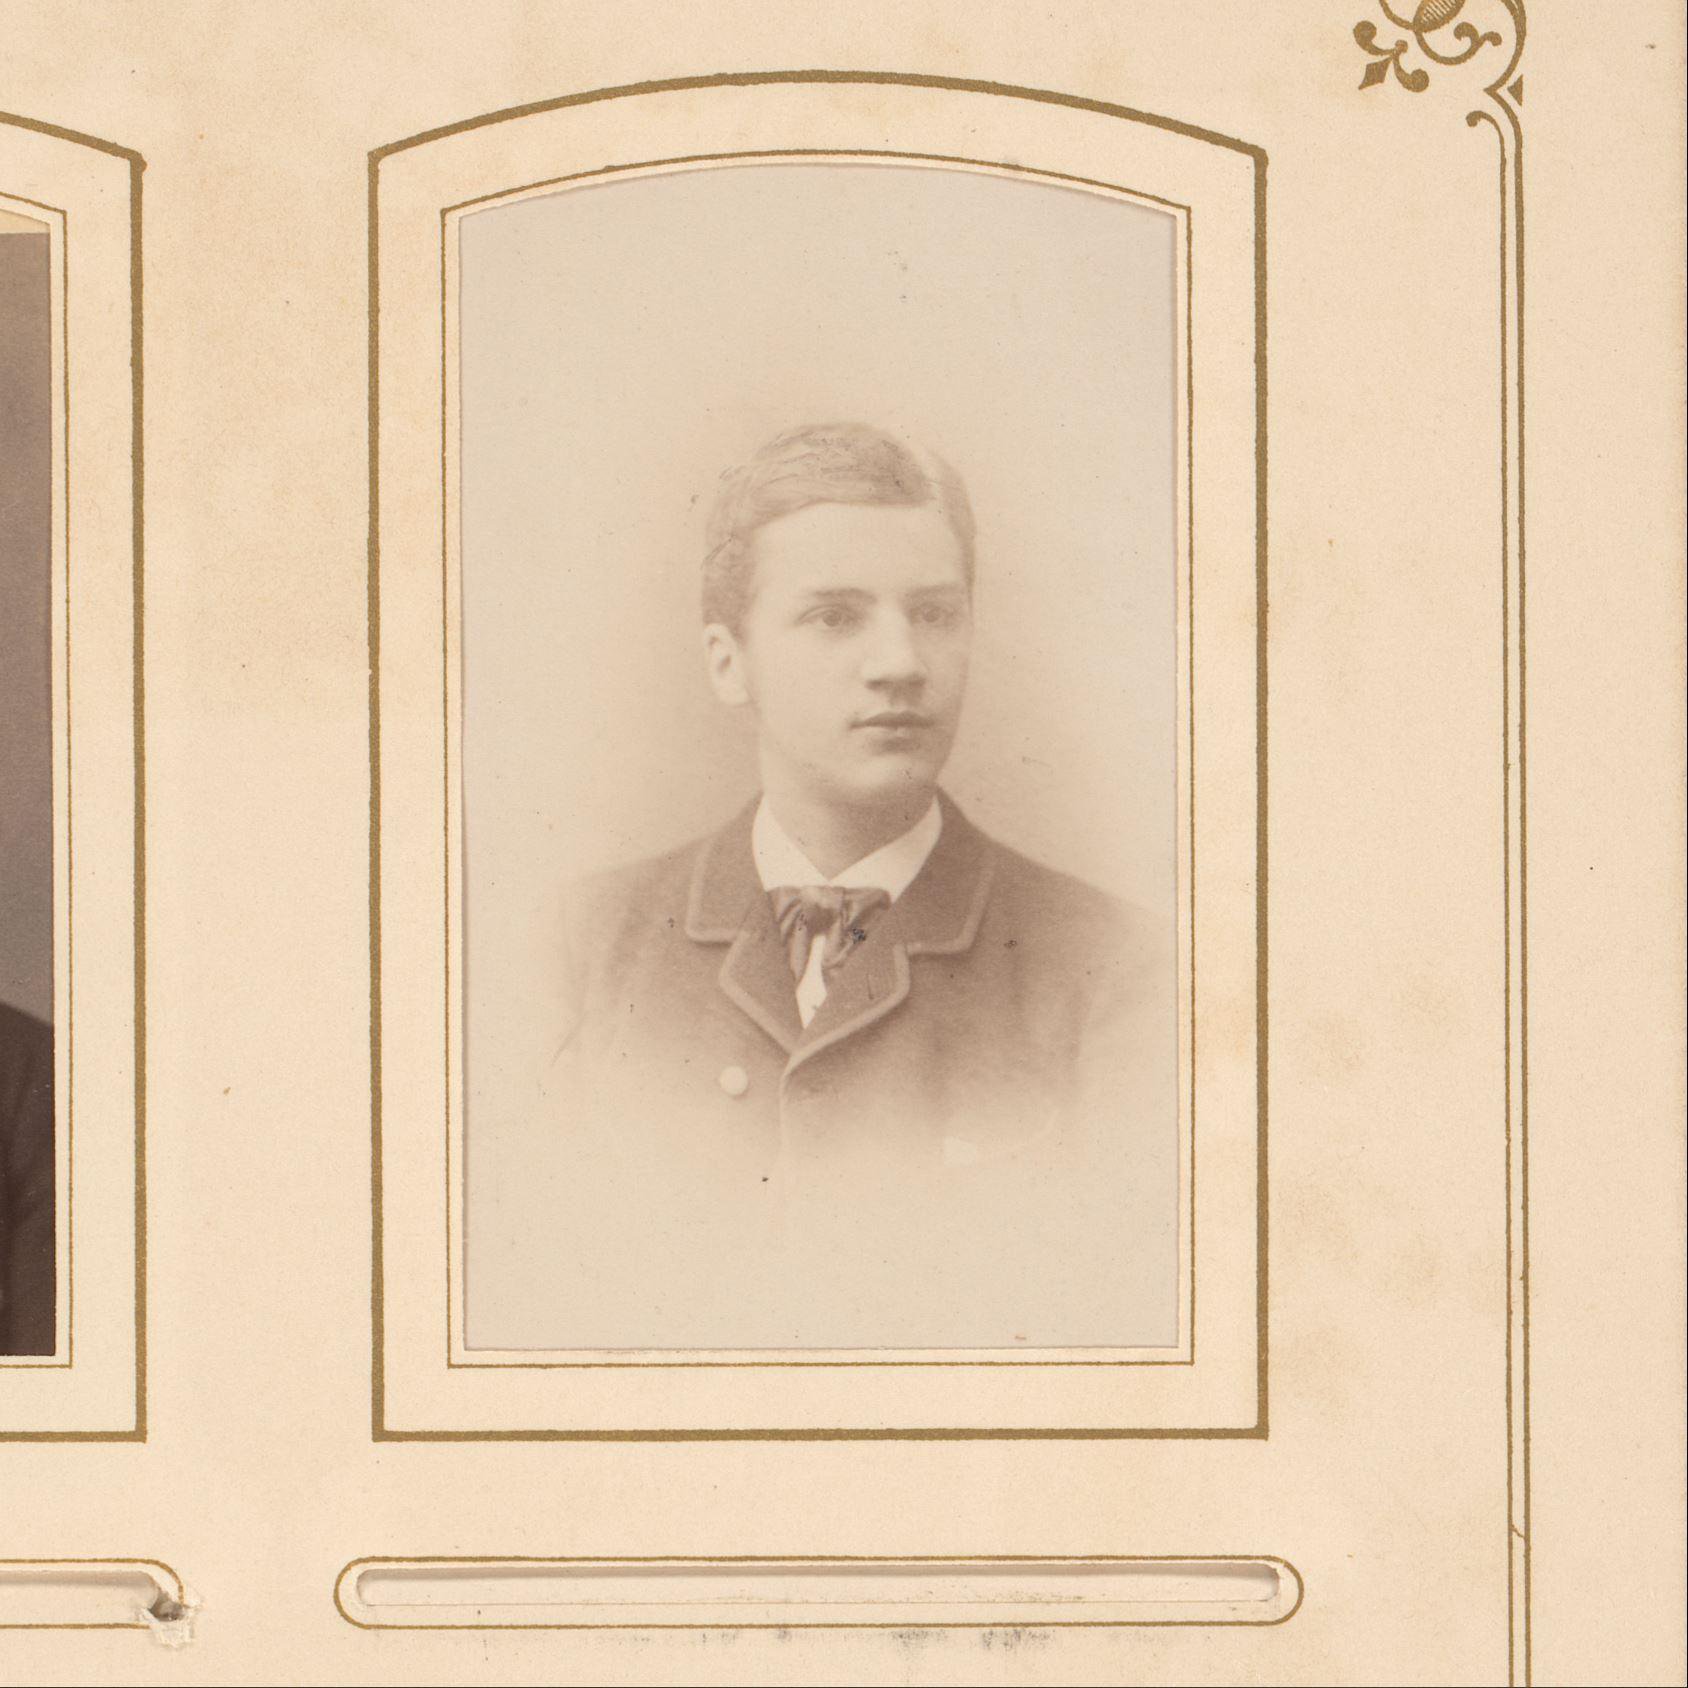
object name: carte de visite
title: Portret van een jonge man, aangeduid als Oscar Visser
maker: laurentius herzog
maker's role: fotograaf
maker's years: 1831-1913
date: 1803-1885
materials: cardboard, photographic support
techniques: albumen print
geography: bremen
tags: historical persons, youth, adolescent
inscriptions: inscription: ‘L. Herzog/ Bremen/ Wall 160.’, annotation: ‘Oscar Visser [...]/ lin[..] zur Erinnerung!/ Bremen. März 1885’